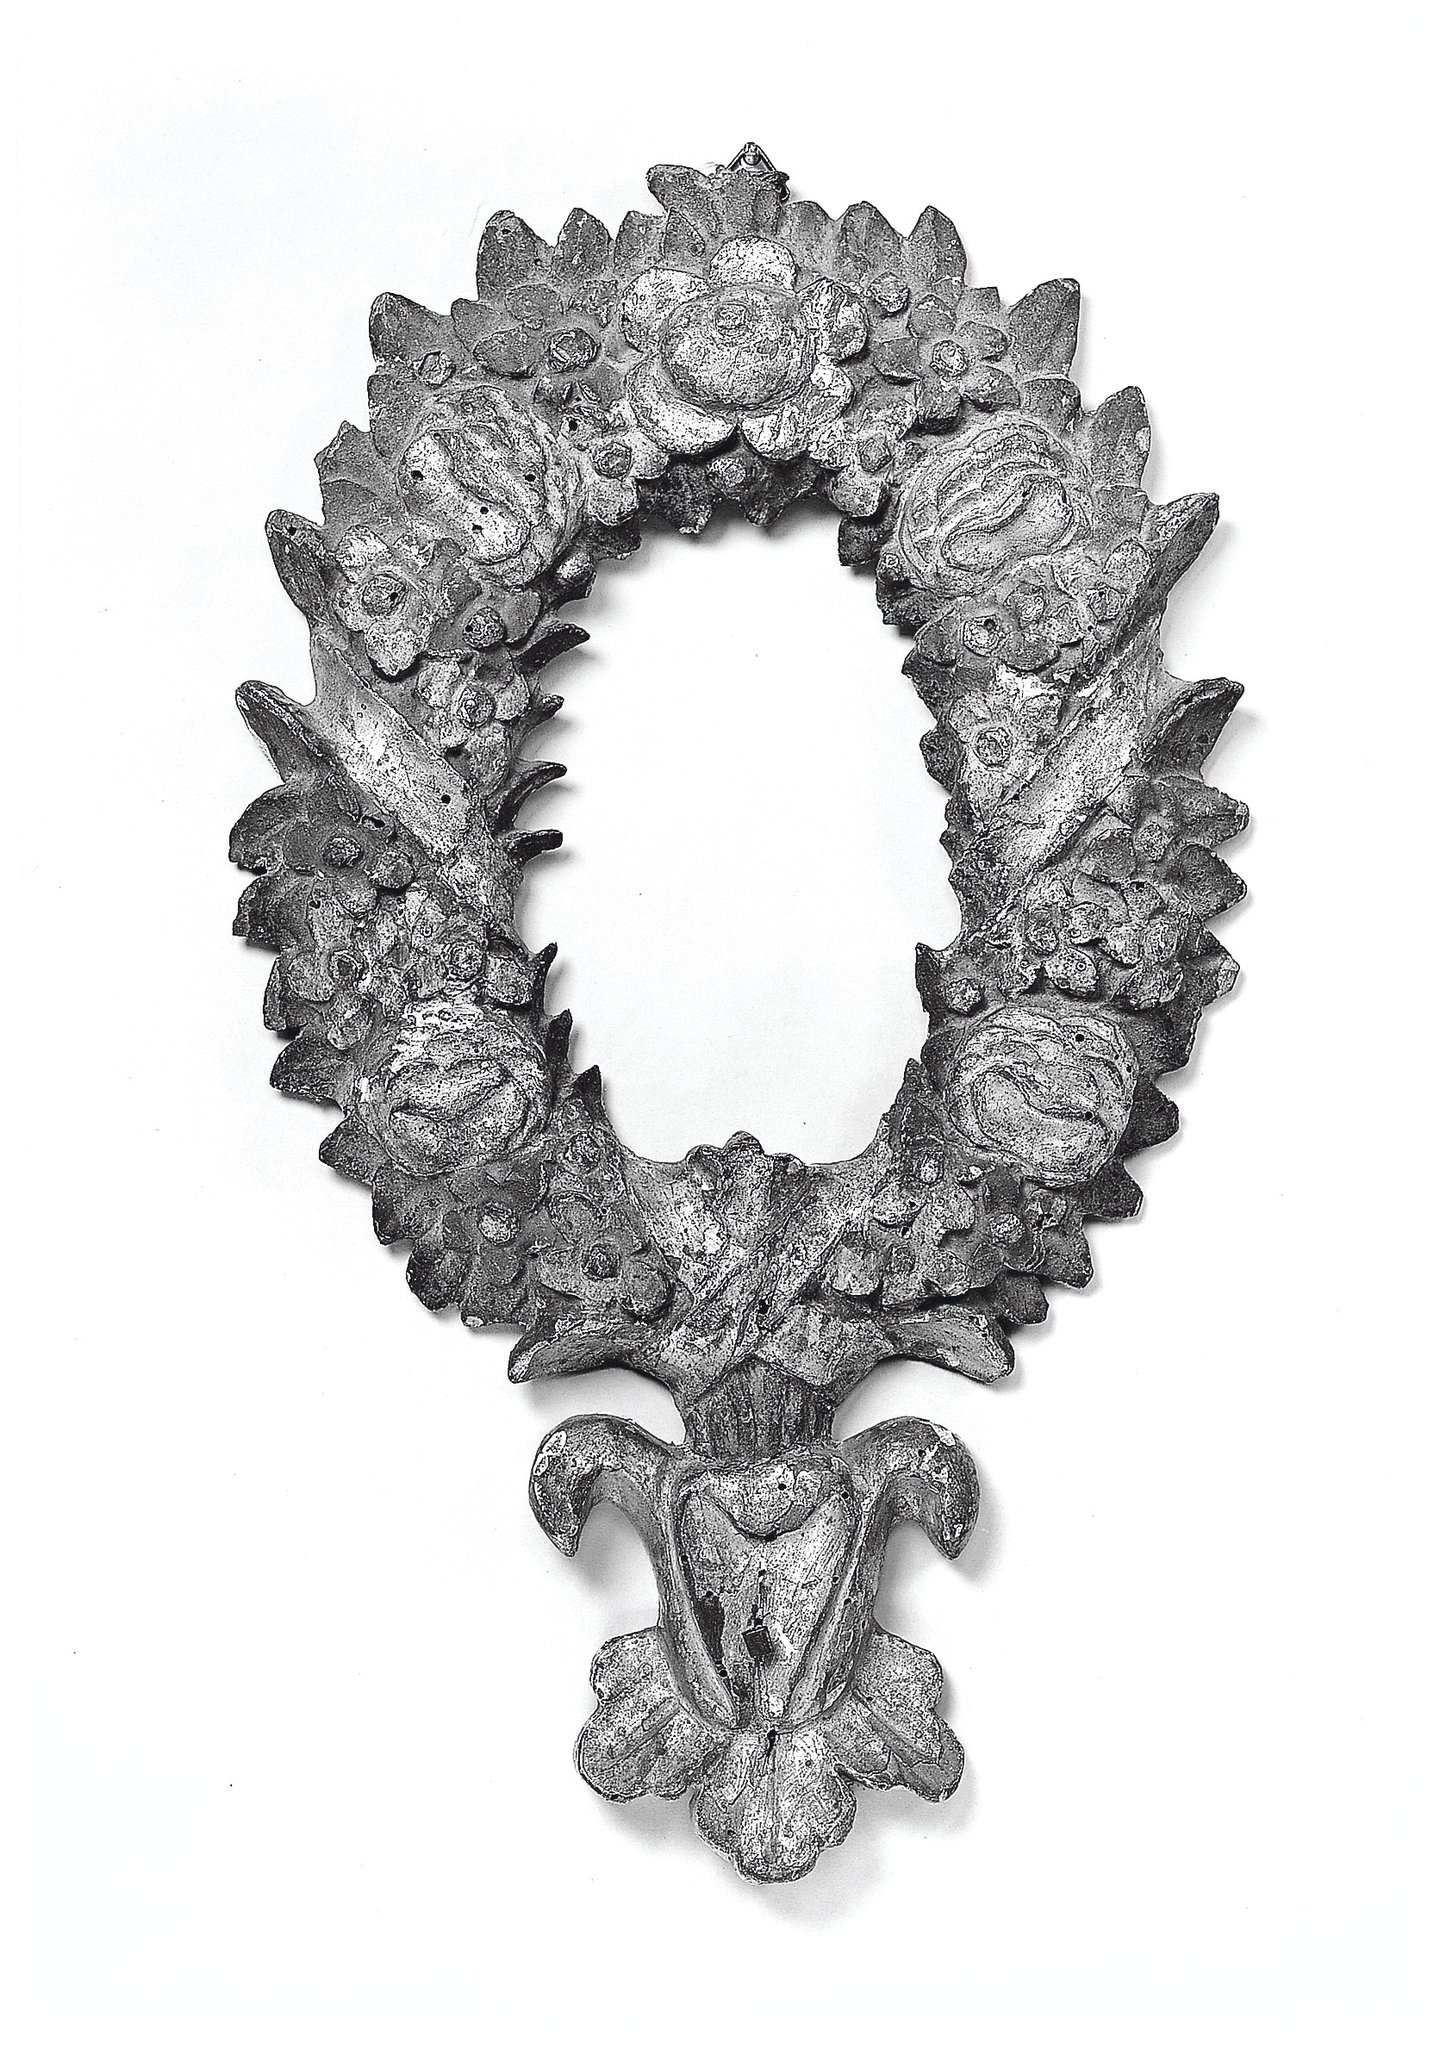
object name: frame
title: Palatina-style oval frame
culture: italian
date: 1767-1800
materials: wood